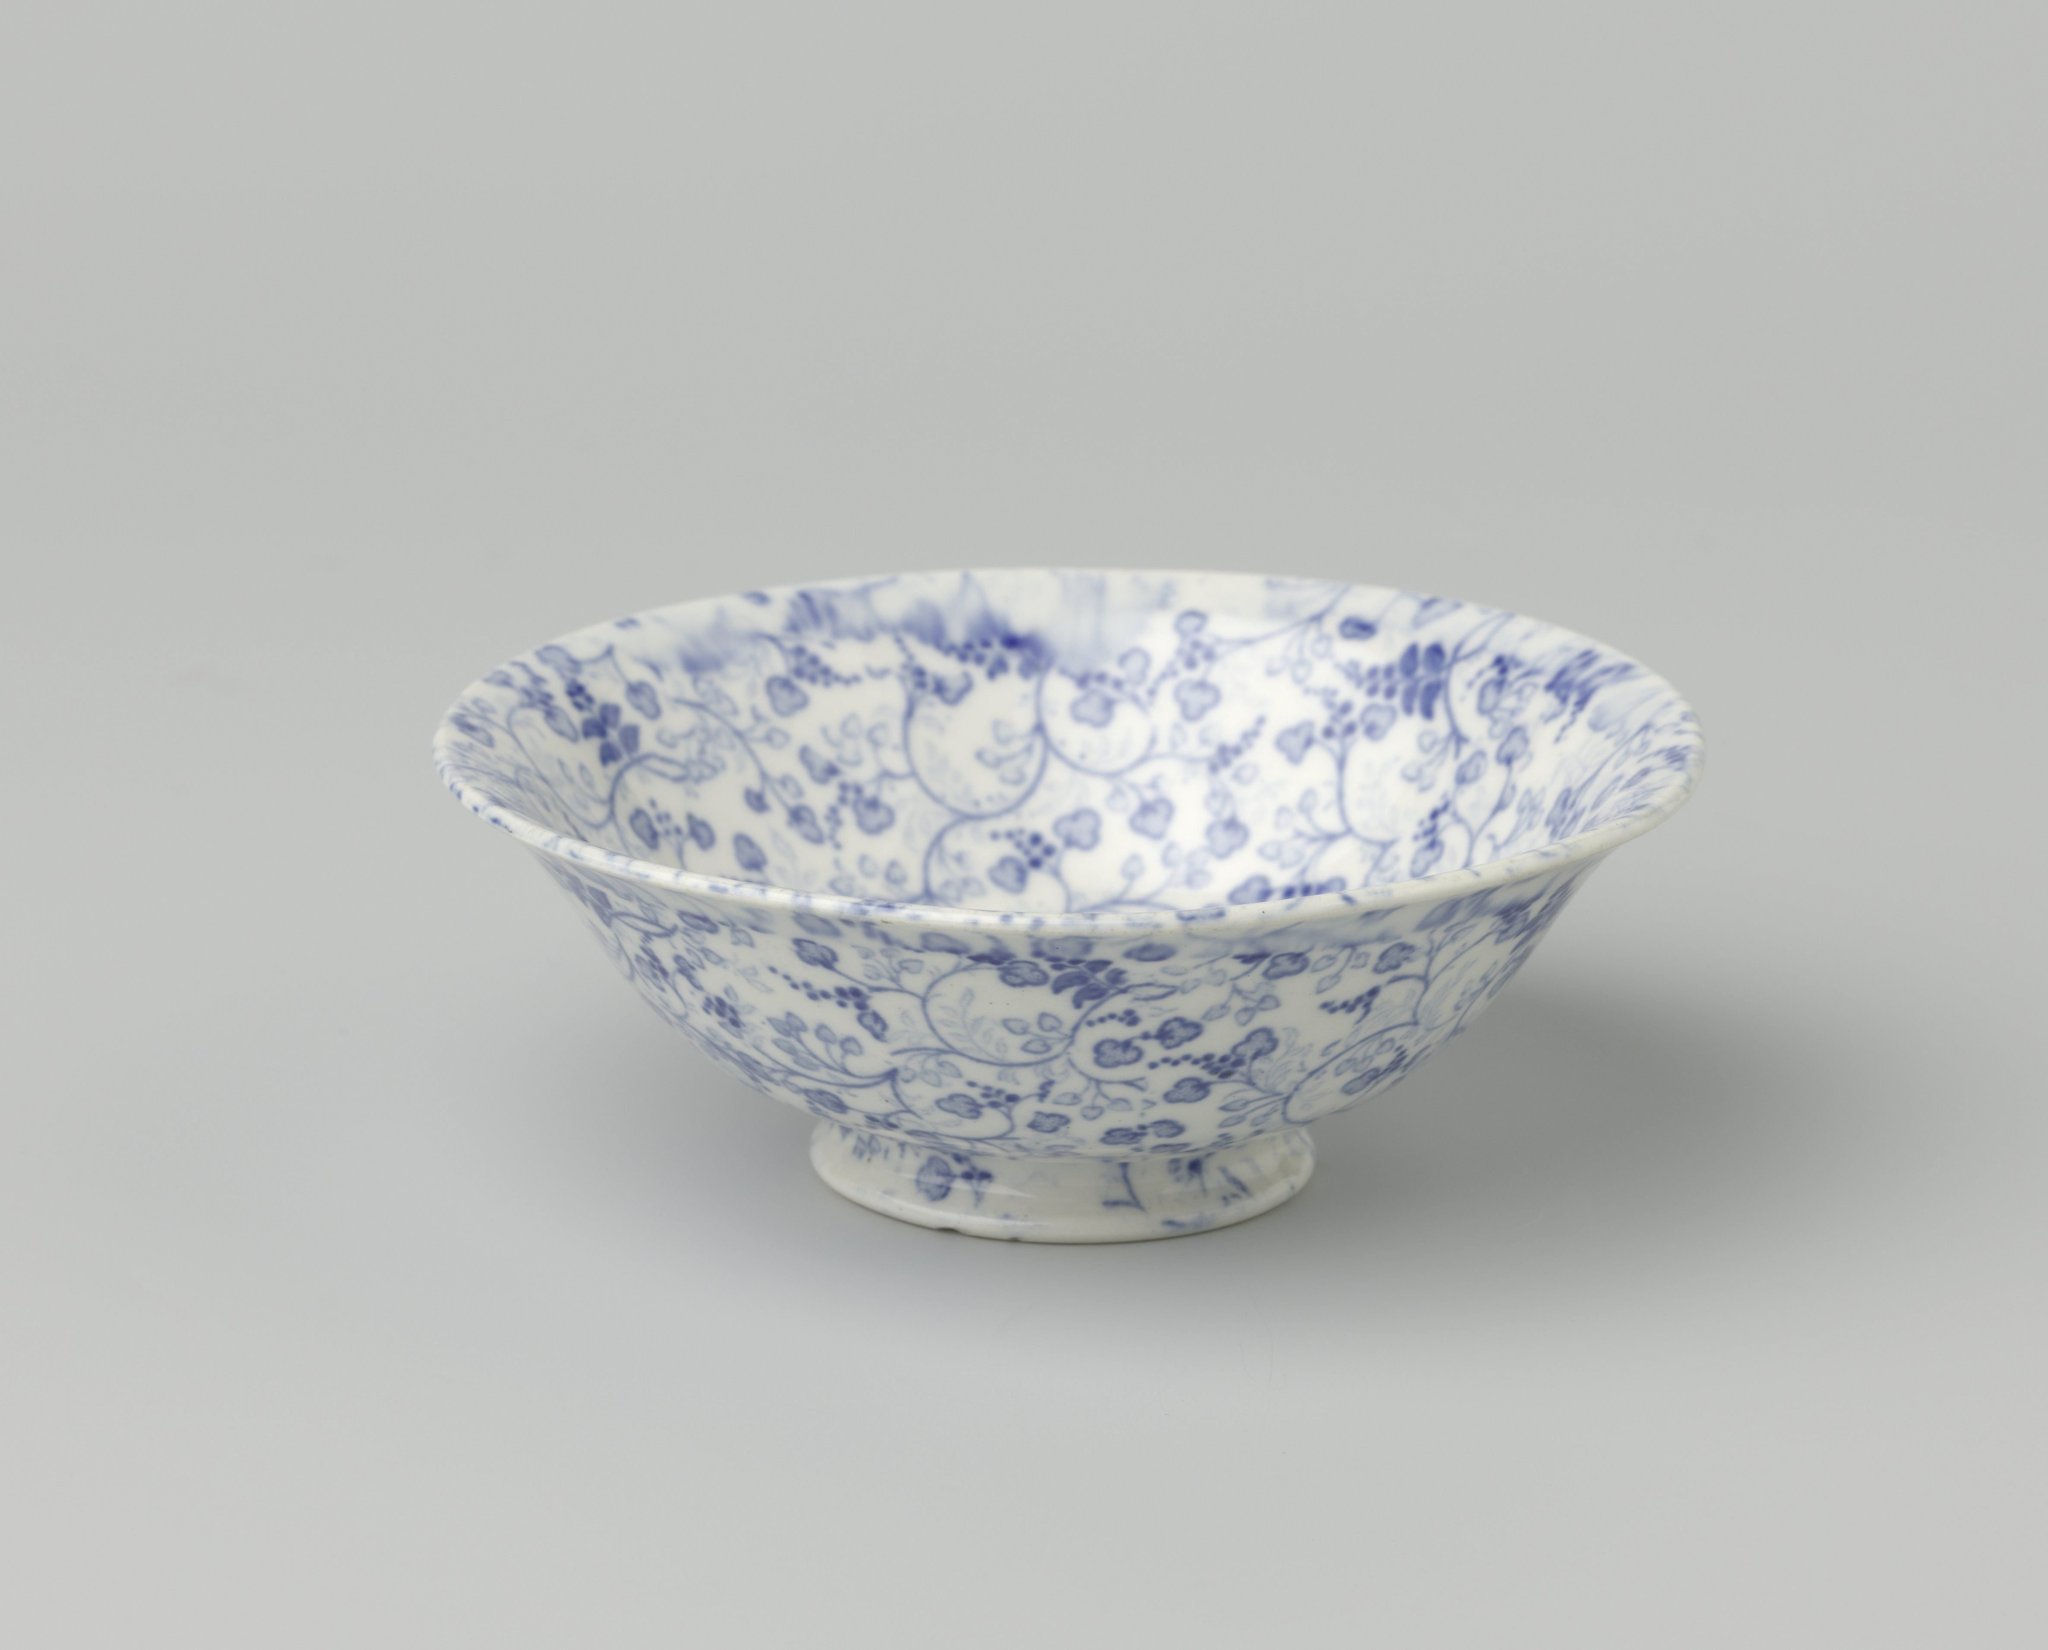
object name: bowl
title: Kom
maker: petrus regout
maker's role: plateelbakker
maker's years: 1801-1879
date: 1867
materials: creamware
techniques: transfer decoration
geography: maastricht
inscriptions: check stamp: ‘PR 12’, mark: ‘PARSEME No 3 2 67’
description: Kom van aardewerk, met blauw doorlopend bloemendecor, behorend tot een kinderservies.